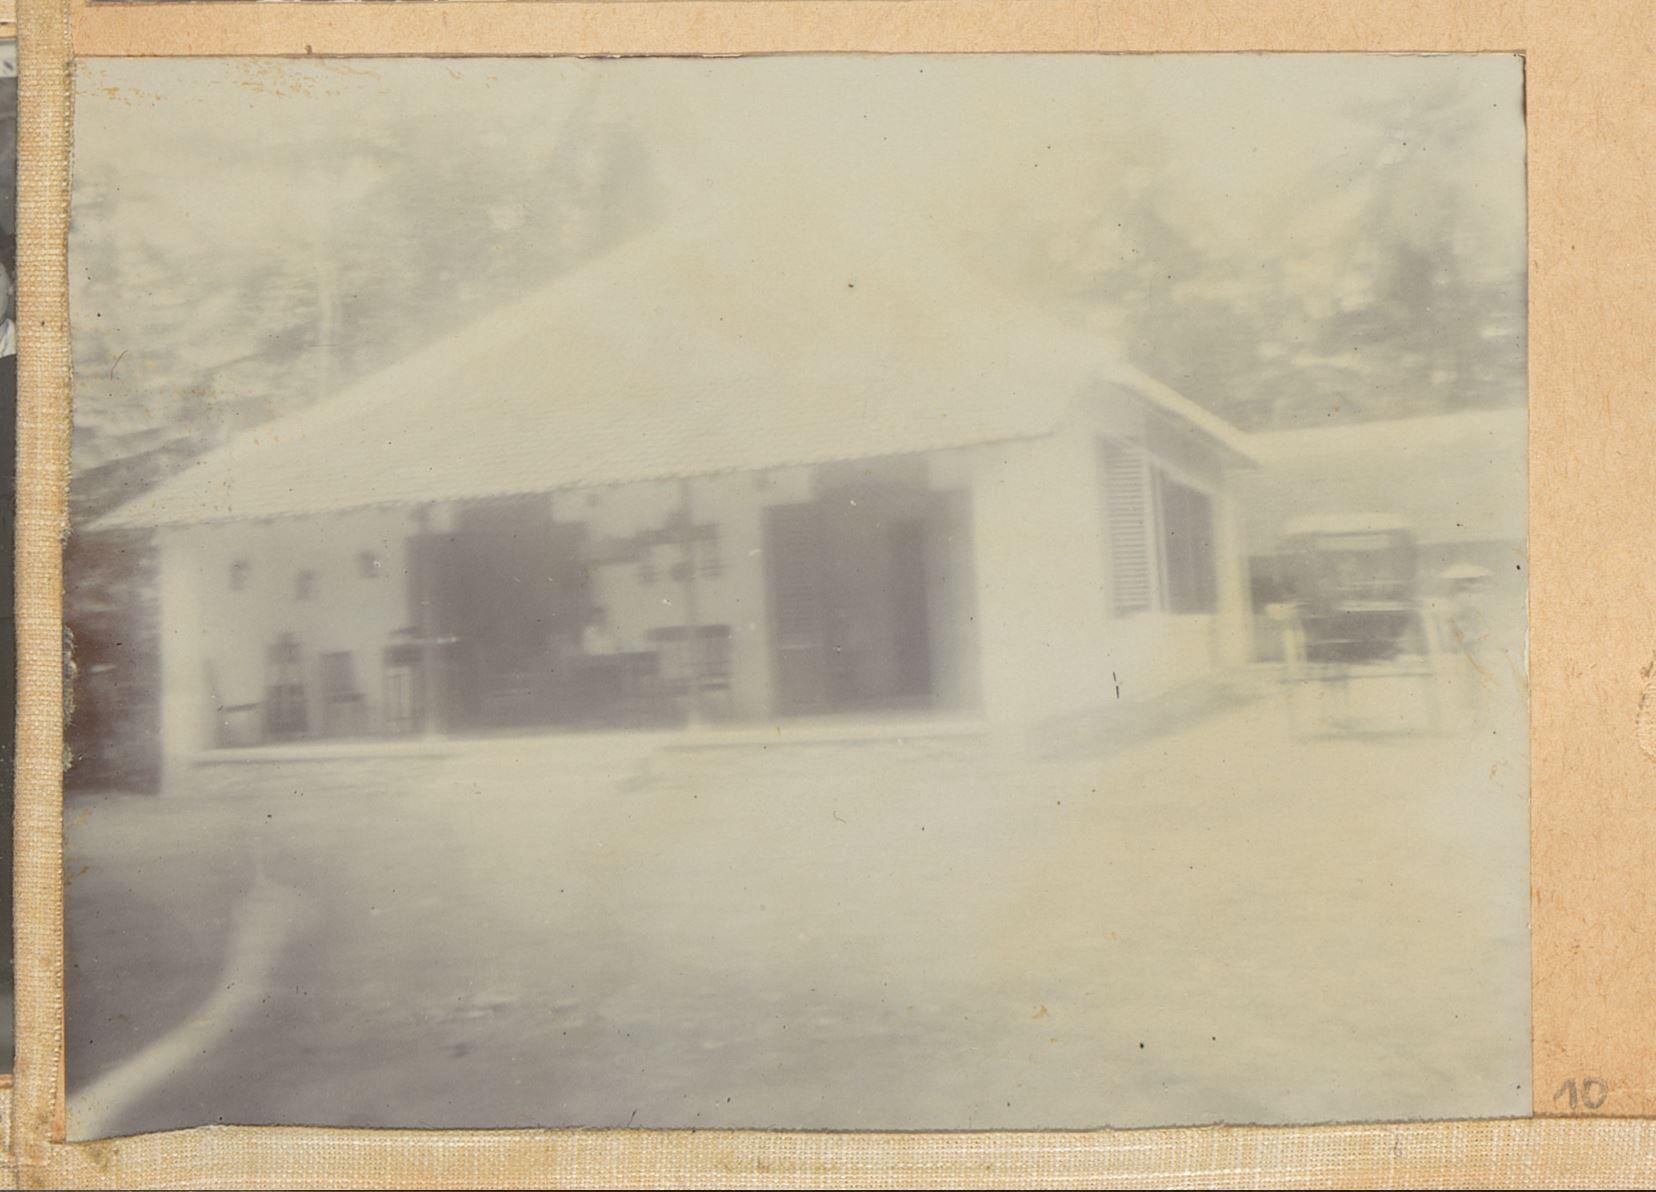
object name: photograph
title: Huis met rijtuig ernaast in Nederlands-Indië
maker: Anonymous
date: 1917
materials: photographic support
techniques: gelatin silver print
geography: dutch east indies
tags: two-wheeled, animal-drawn vehicle, the usual house or row of houses, dutch east indies, the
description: Onderdeel van Familiealbum met foto's van een familie in de voormalige kolonie Nederlands-Indië en van een suikerfabriek in Purworejo.